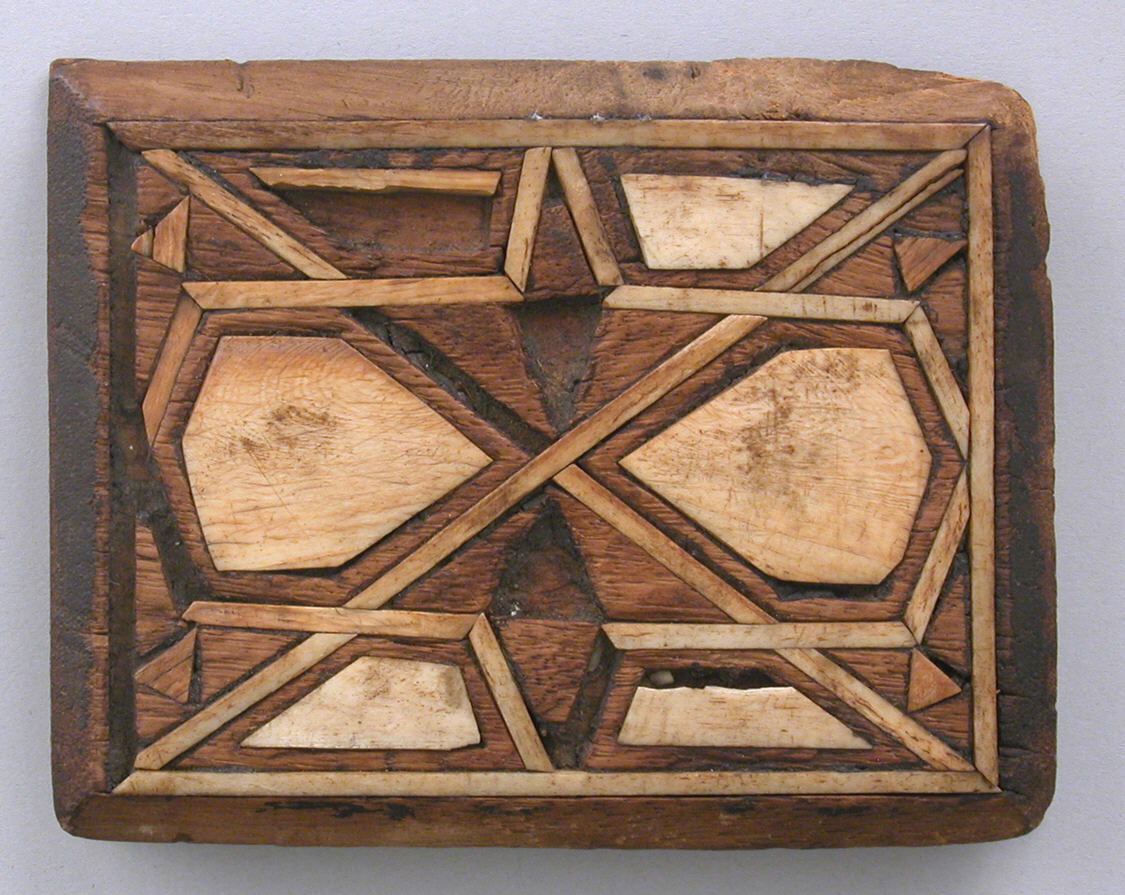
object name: panel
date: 1301-1500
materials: ivory, wood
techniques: carving, inlay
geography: egypt